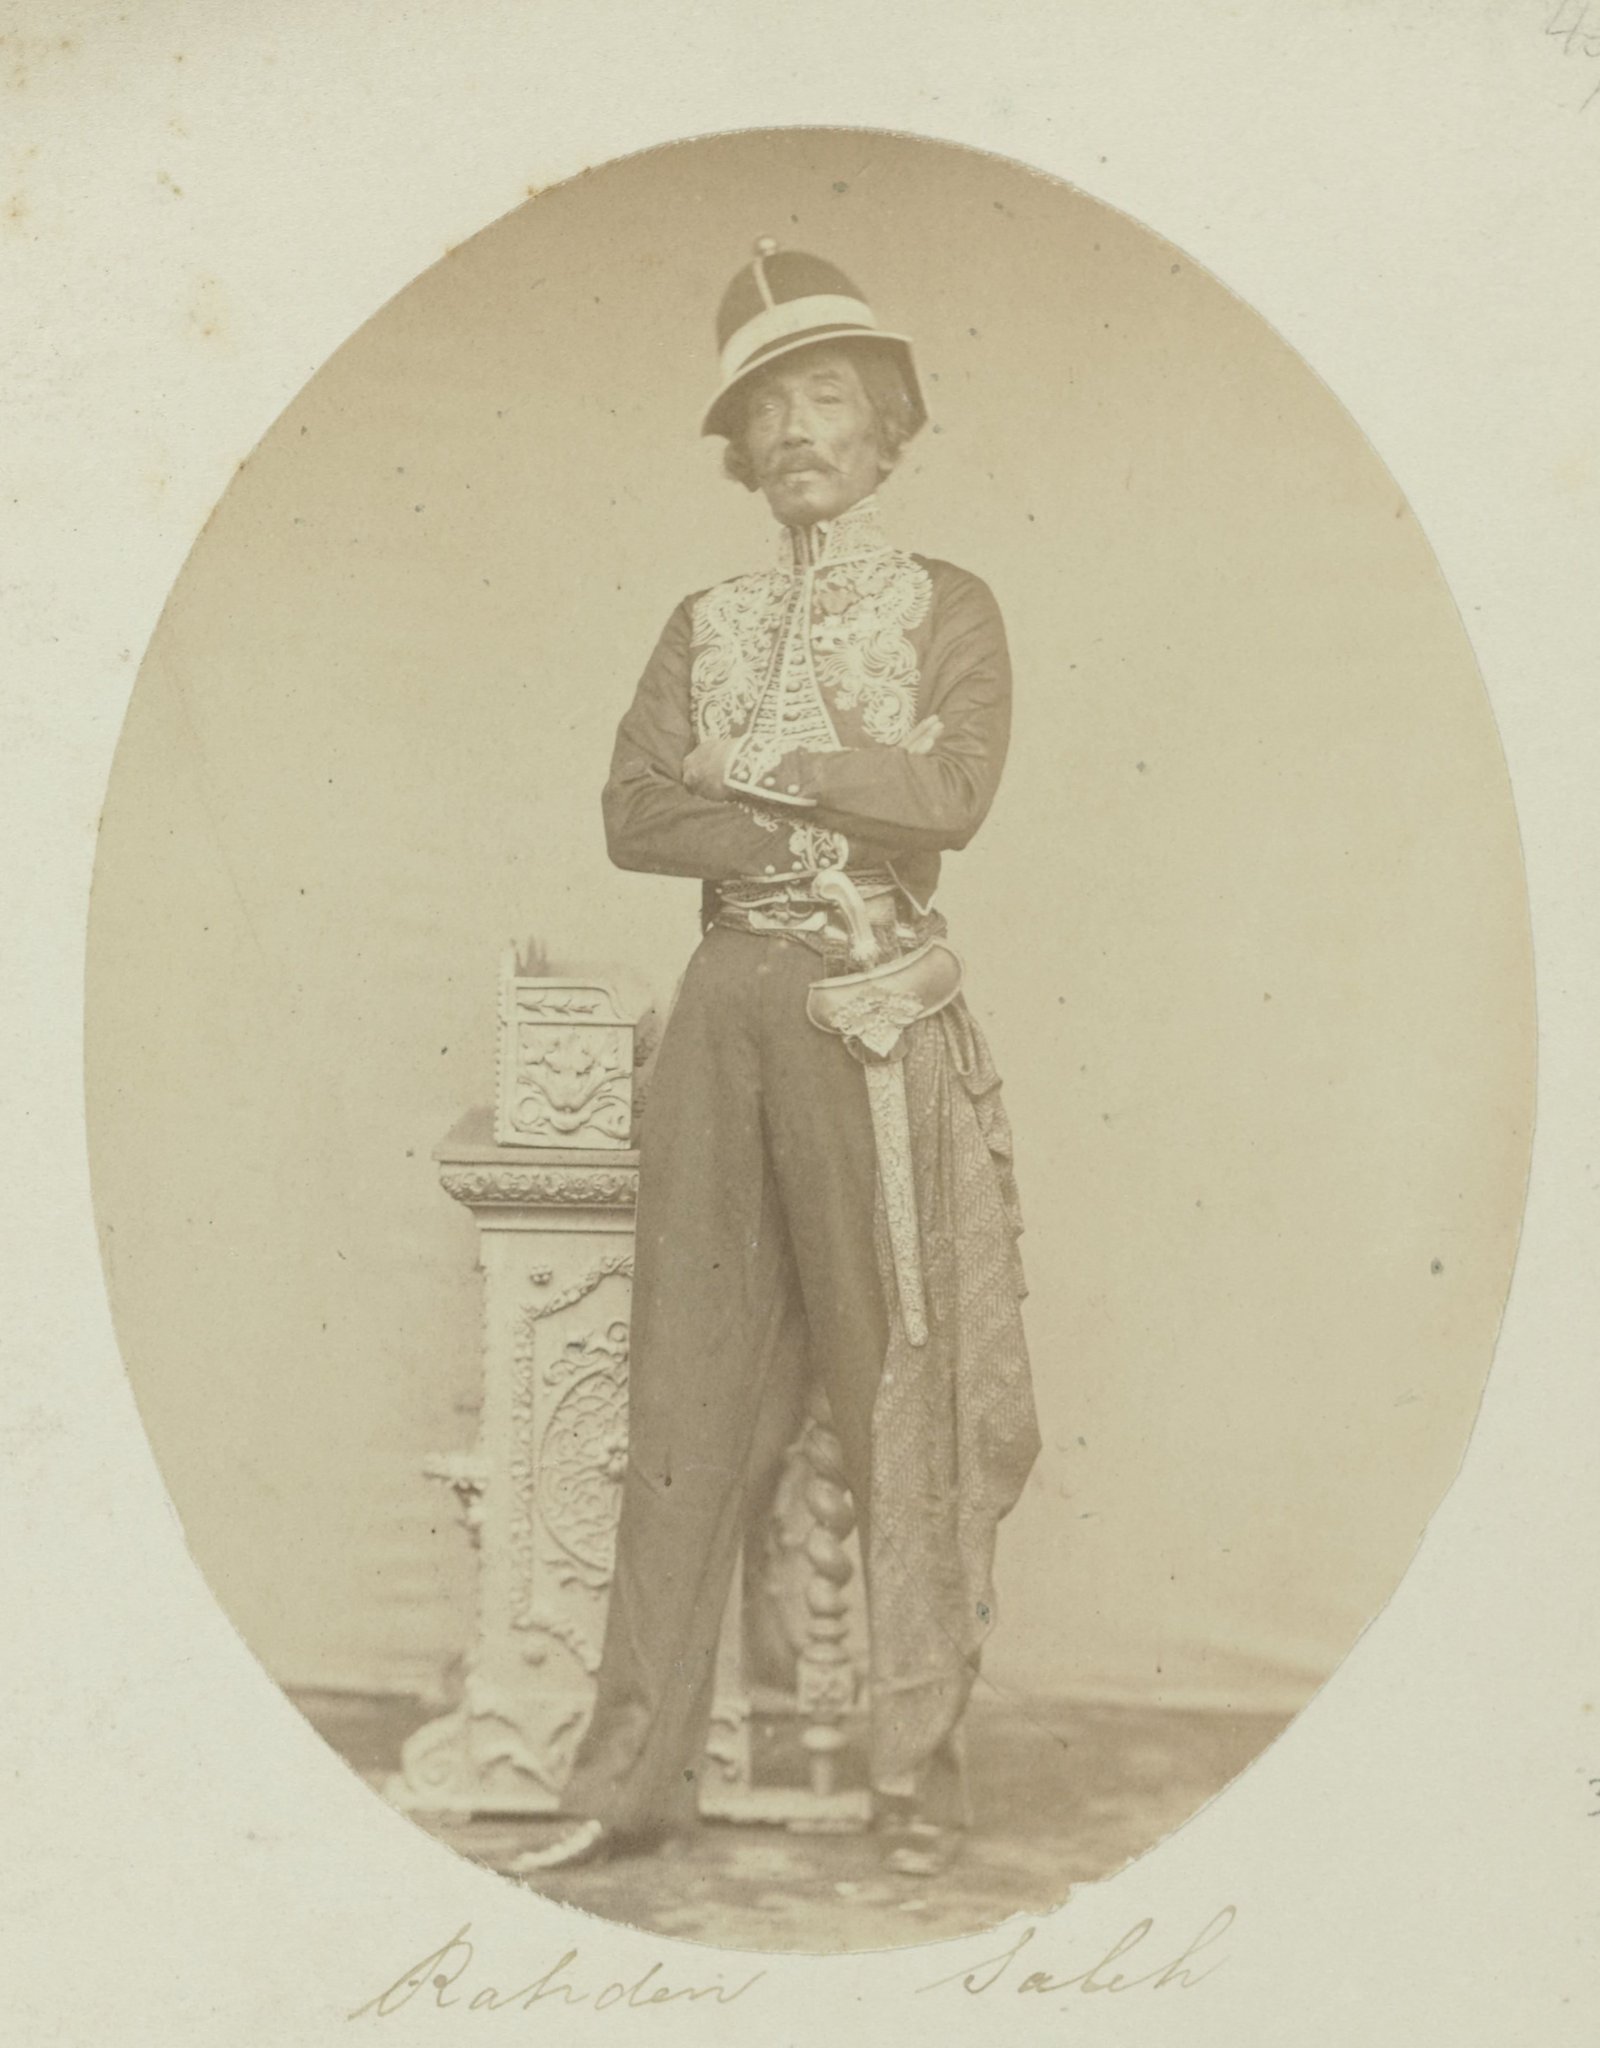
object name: photograph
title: Rahden Saleh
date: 1863-1869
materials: photographic support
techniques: albumen print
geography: java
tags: painter, draughtsman, raden sarief bastaman saleh, historical persons, portrait, self-portrait of painter, portrait, self-portrait of artist, java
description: Portret van de Indische schilder Raden Saleh, in uniform met helm op het hoofd, de armen over elkaar, staande voor een schrijftafel of kastje. Onderdeel van het groene fotoalbum met foto's van Java, uit het bezit van apotheker Specht-Grijp, die in 1865 vanuit Batavia naar Nederland terugkeerde.